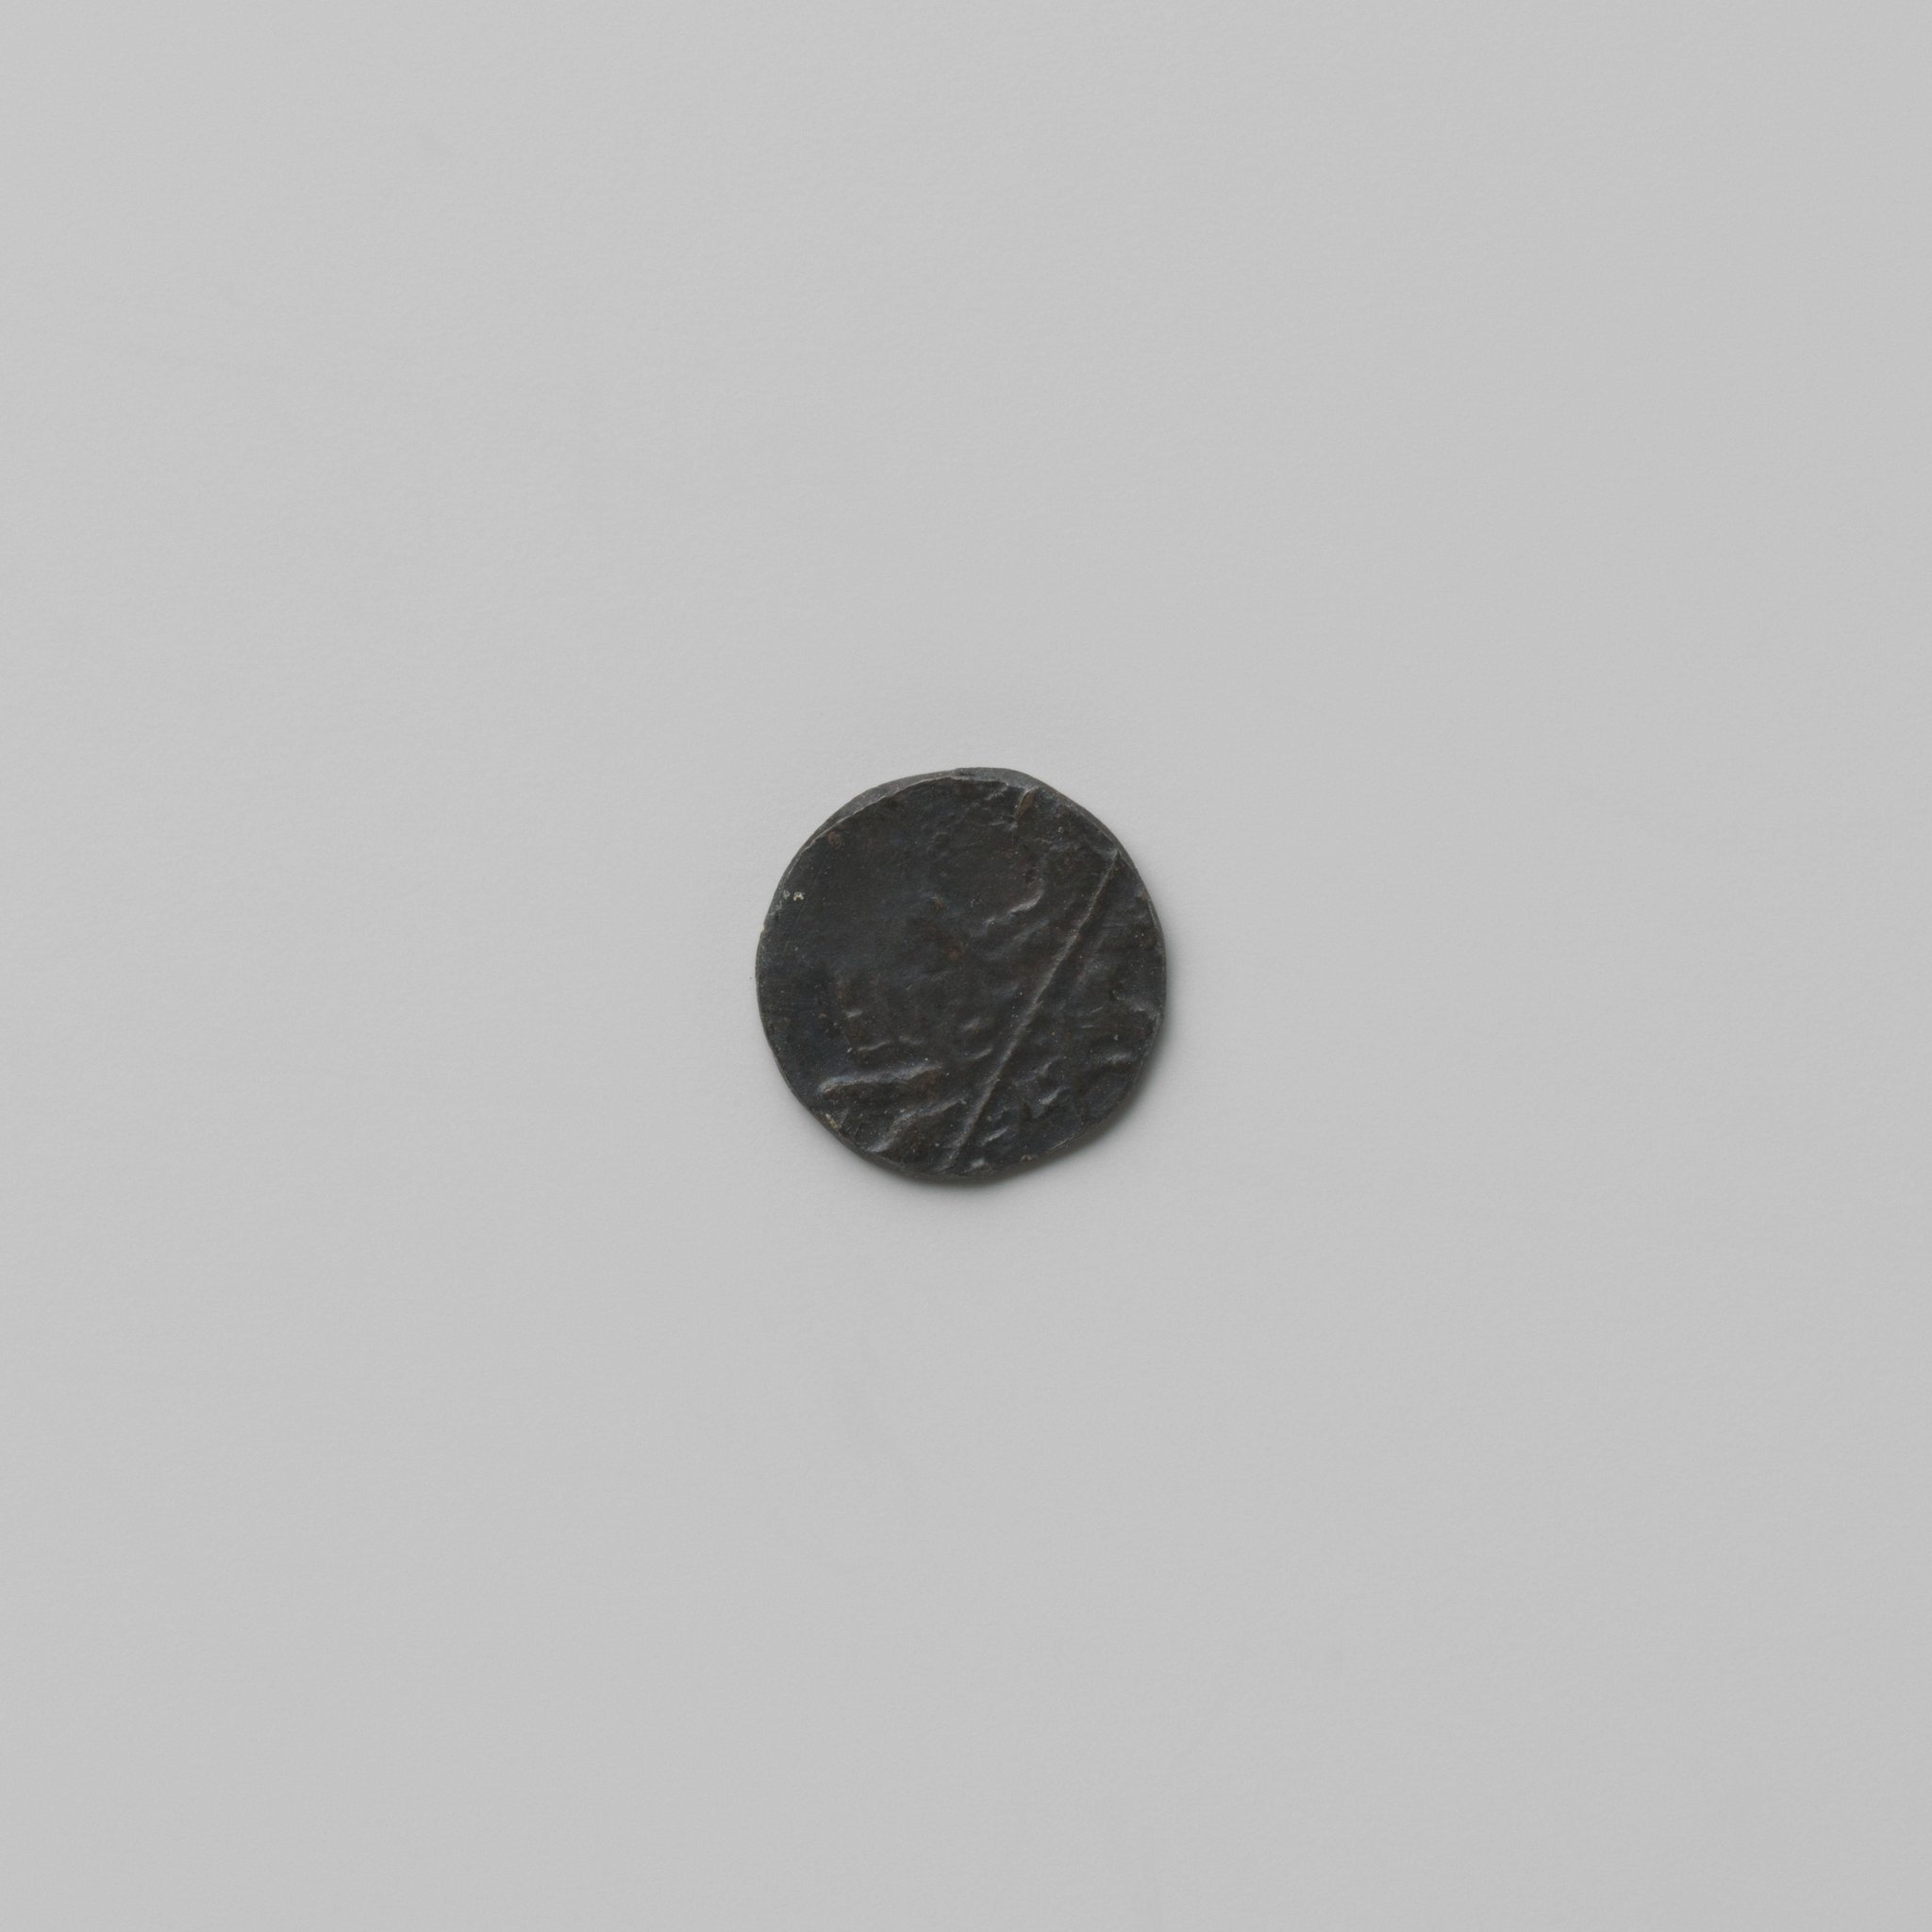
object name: miniature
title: Russische kopek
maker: Anonymous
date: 1650-1710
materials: silver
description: Zilveren muntje; Russisch kopek met ronde vorm, van Alexis Michaelowitz, czaar van Rusland (1645 - 1676).